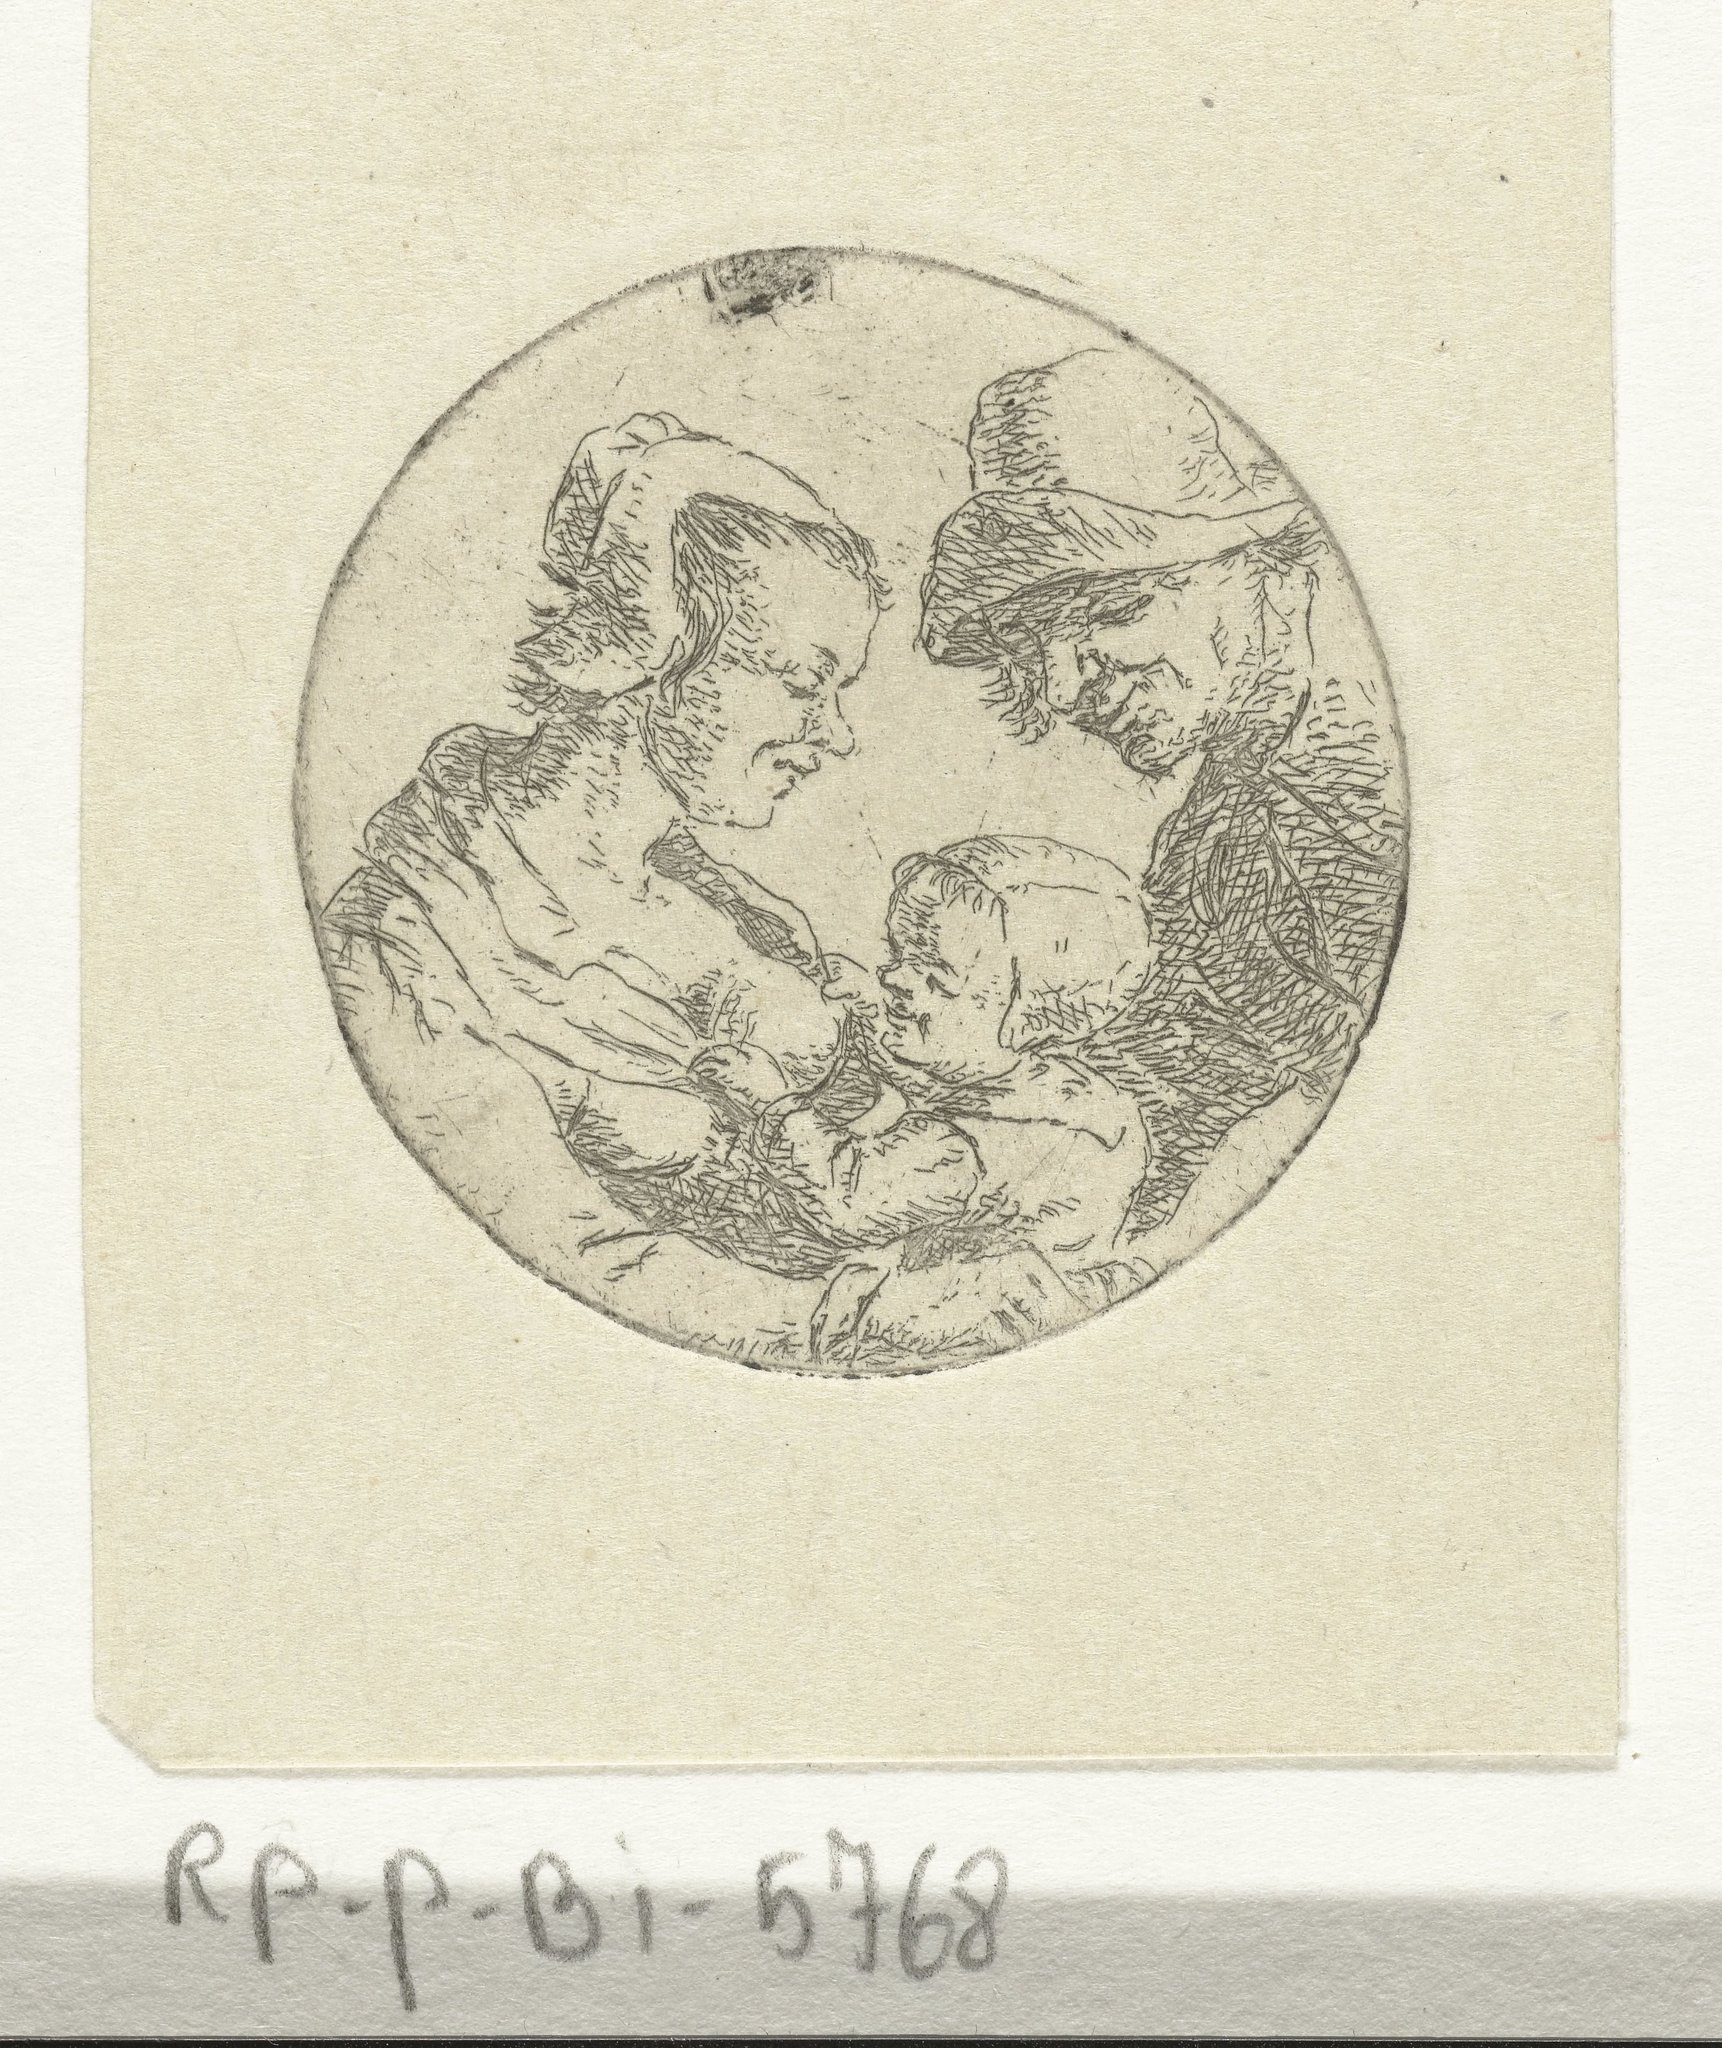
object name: print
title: Boer en boerin met kind (versie 1)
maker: christina chalon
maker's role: draughtsman, print maker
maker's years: 1748-1808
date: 1758-1808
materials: paper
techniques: etching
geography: leiden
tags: nursing, suckling, farmers, family group, especially parents with their child(ren) (with number of children)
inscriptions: collector's mark: Lugt 2228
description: Portret in ronde lijst van een onbekende boerenfamilie. Een vrouw geeft haar kind de borst terwijl haar man vertederd toekijkt.